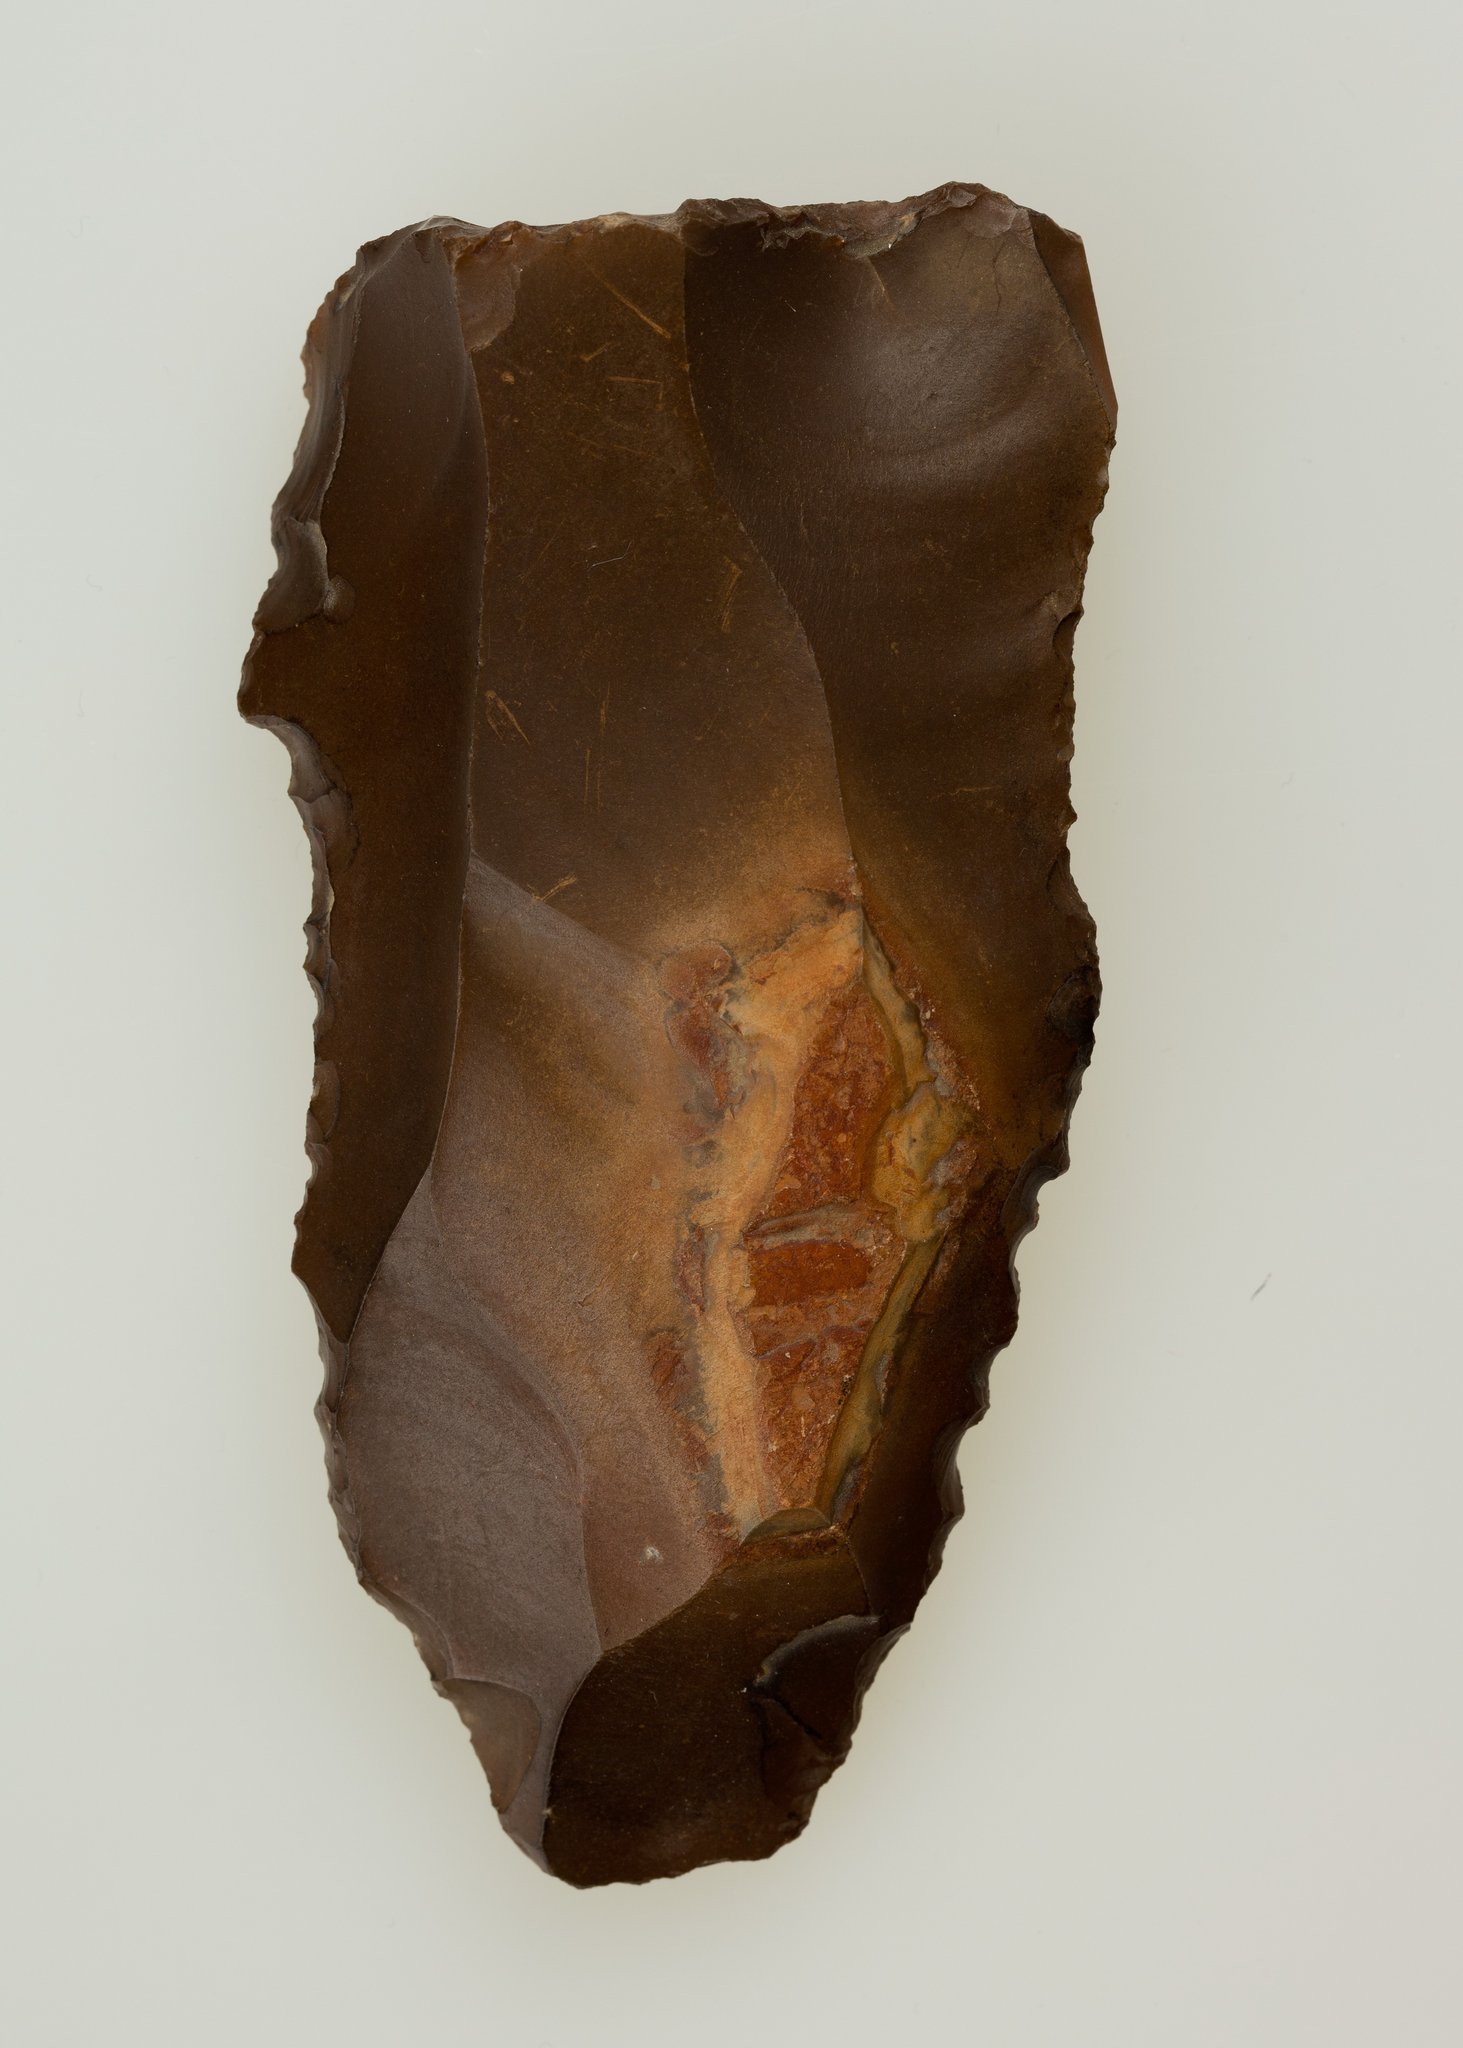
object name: tool, denticulate, levallois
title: Denticulated Tool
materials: stone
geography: egypt